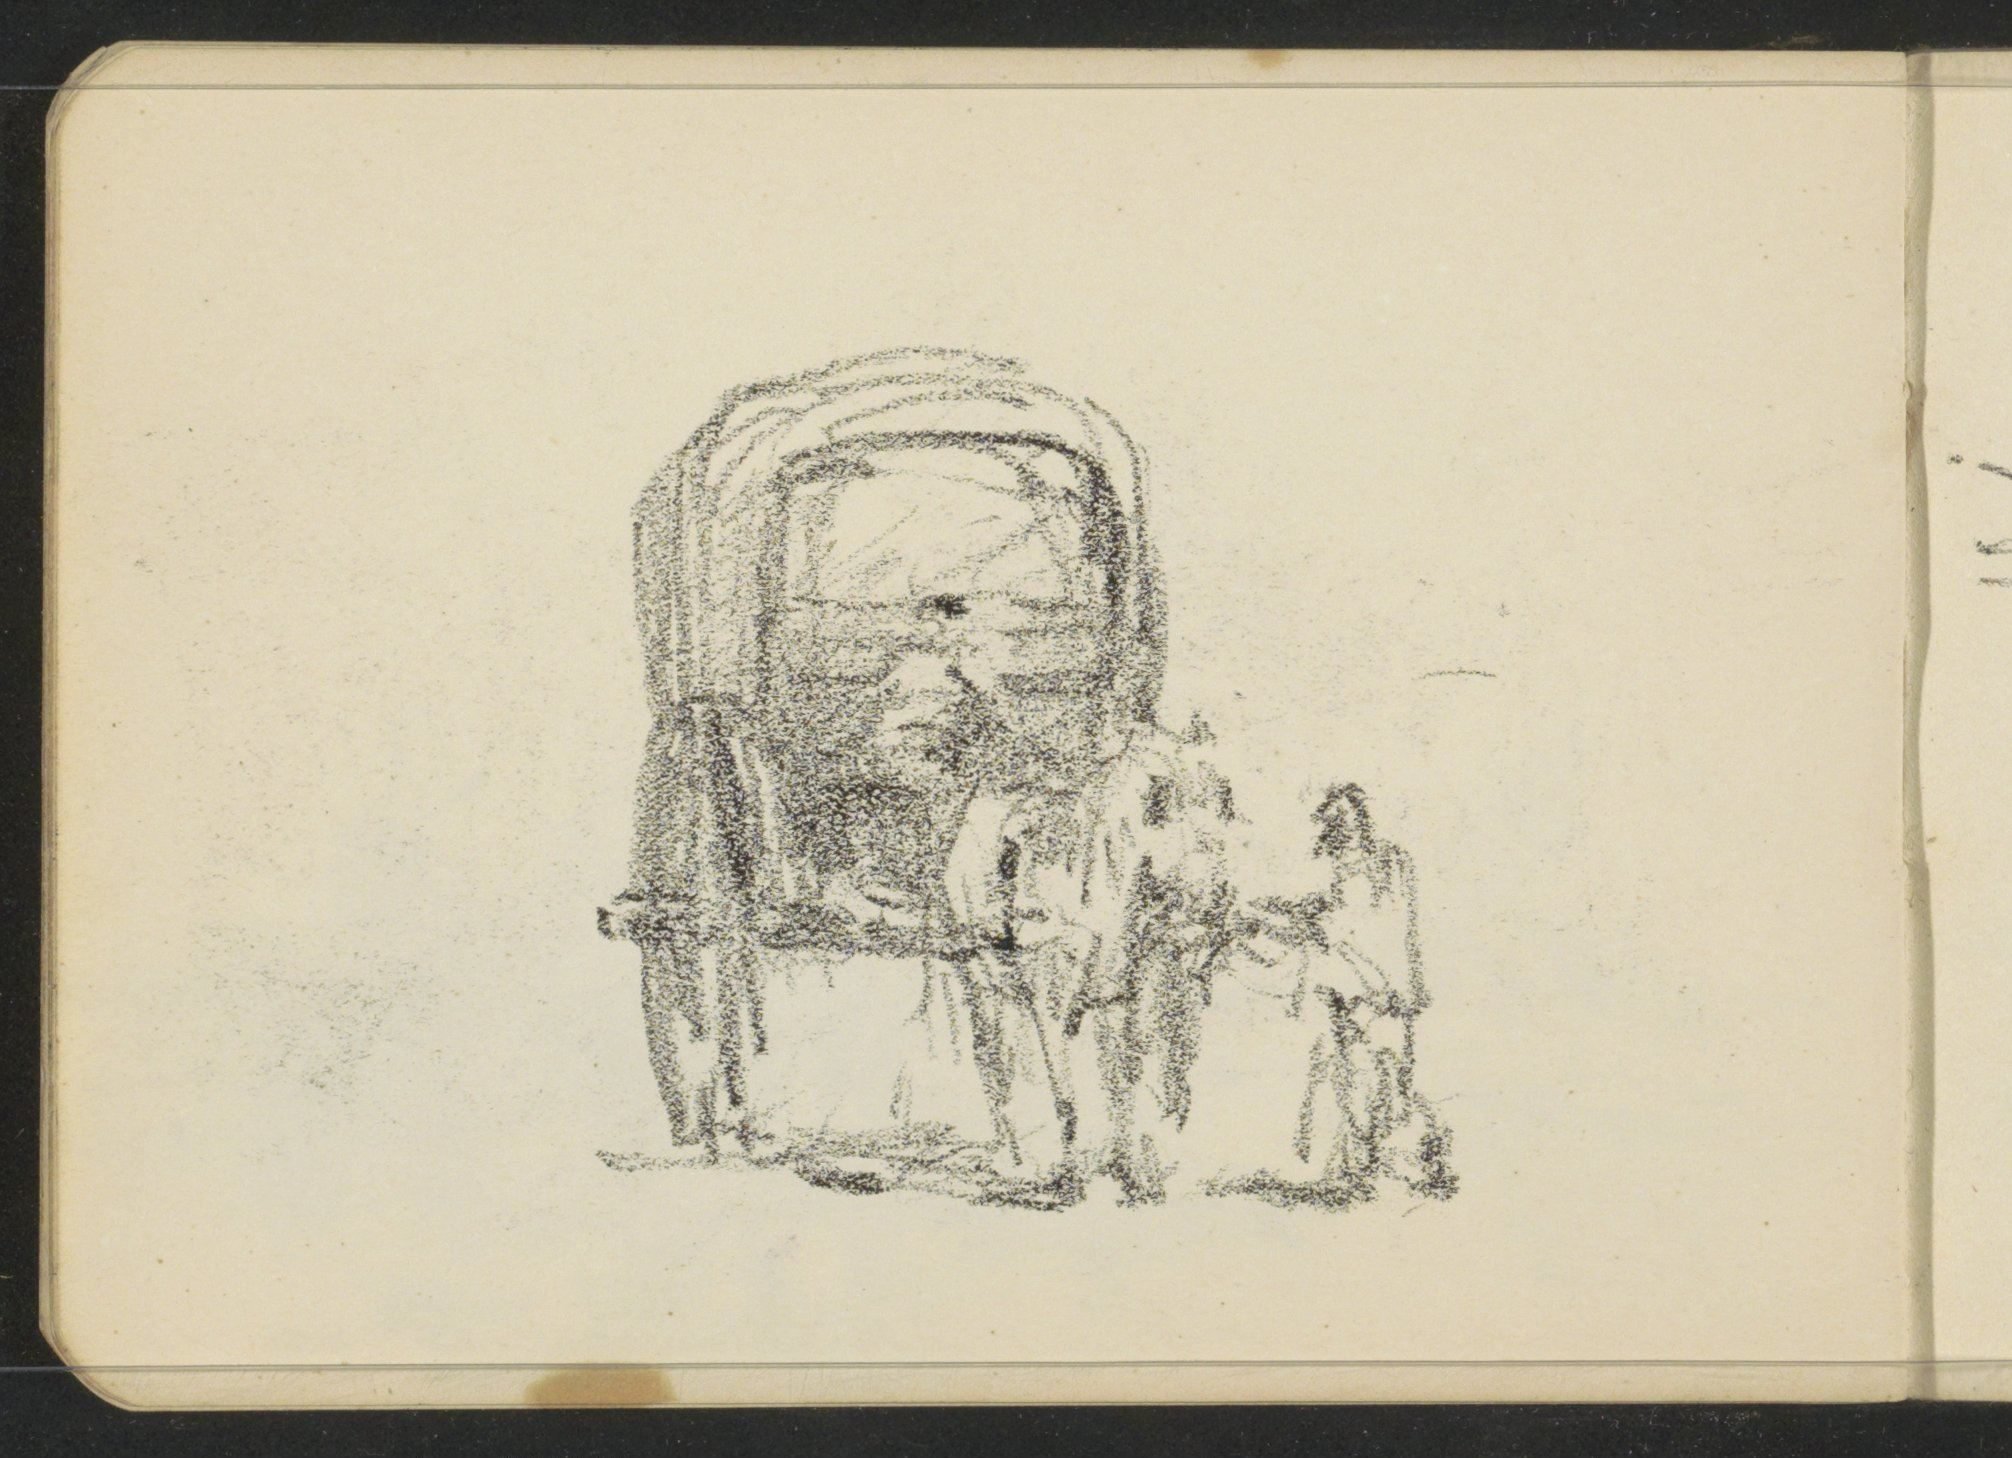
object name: sketchbook leaf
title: Man naast een paard voor een huifkar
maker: willem cornelis rip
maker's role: draughtsman, painter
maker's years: 1856-1922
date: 1914-1916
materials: chalk, paper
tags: covered wagon, hooded wagon, horse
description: Blad 7 verso uit een schetsboek met 41 bladen.